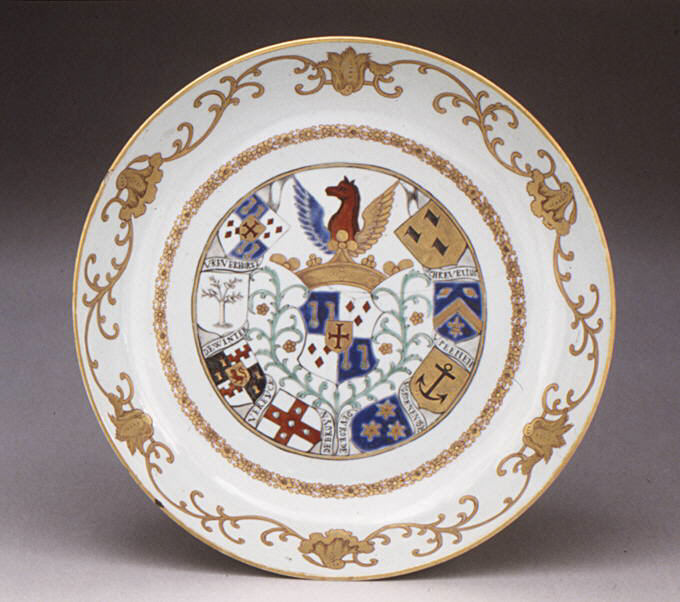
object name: dish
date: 1745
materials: hard paste porcelain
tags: coat of arms